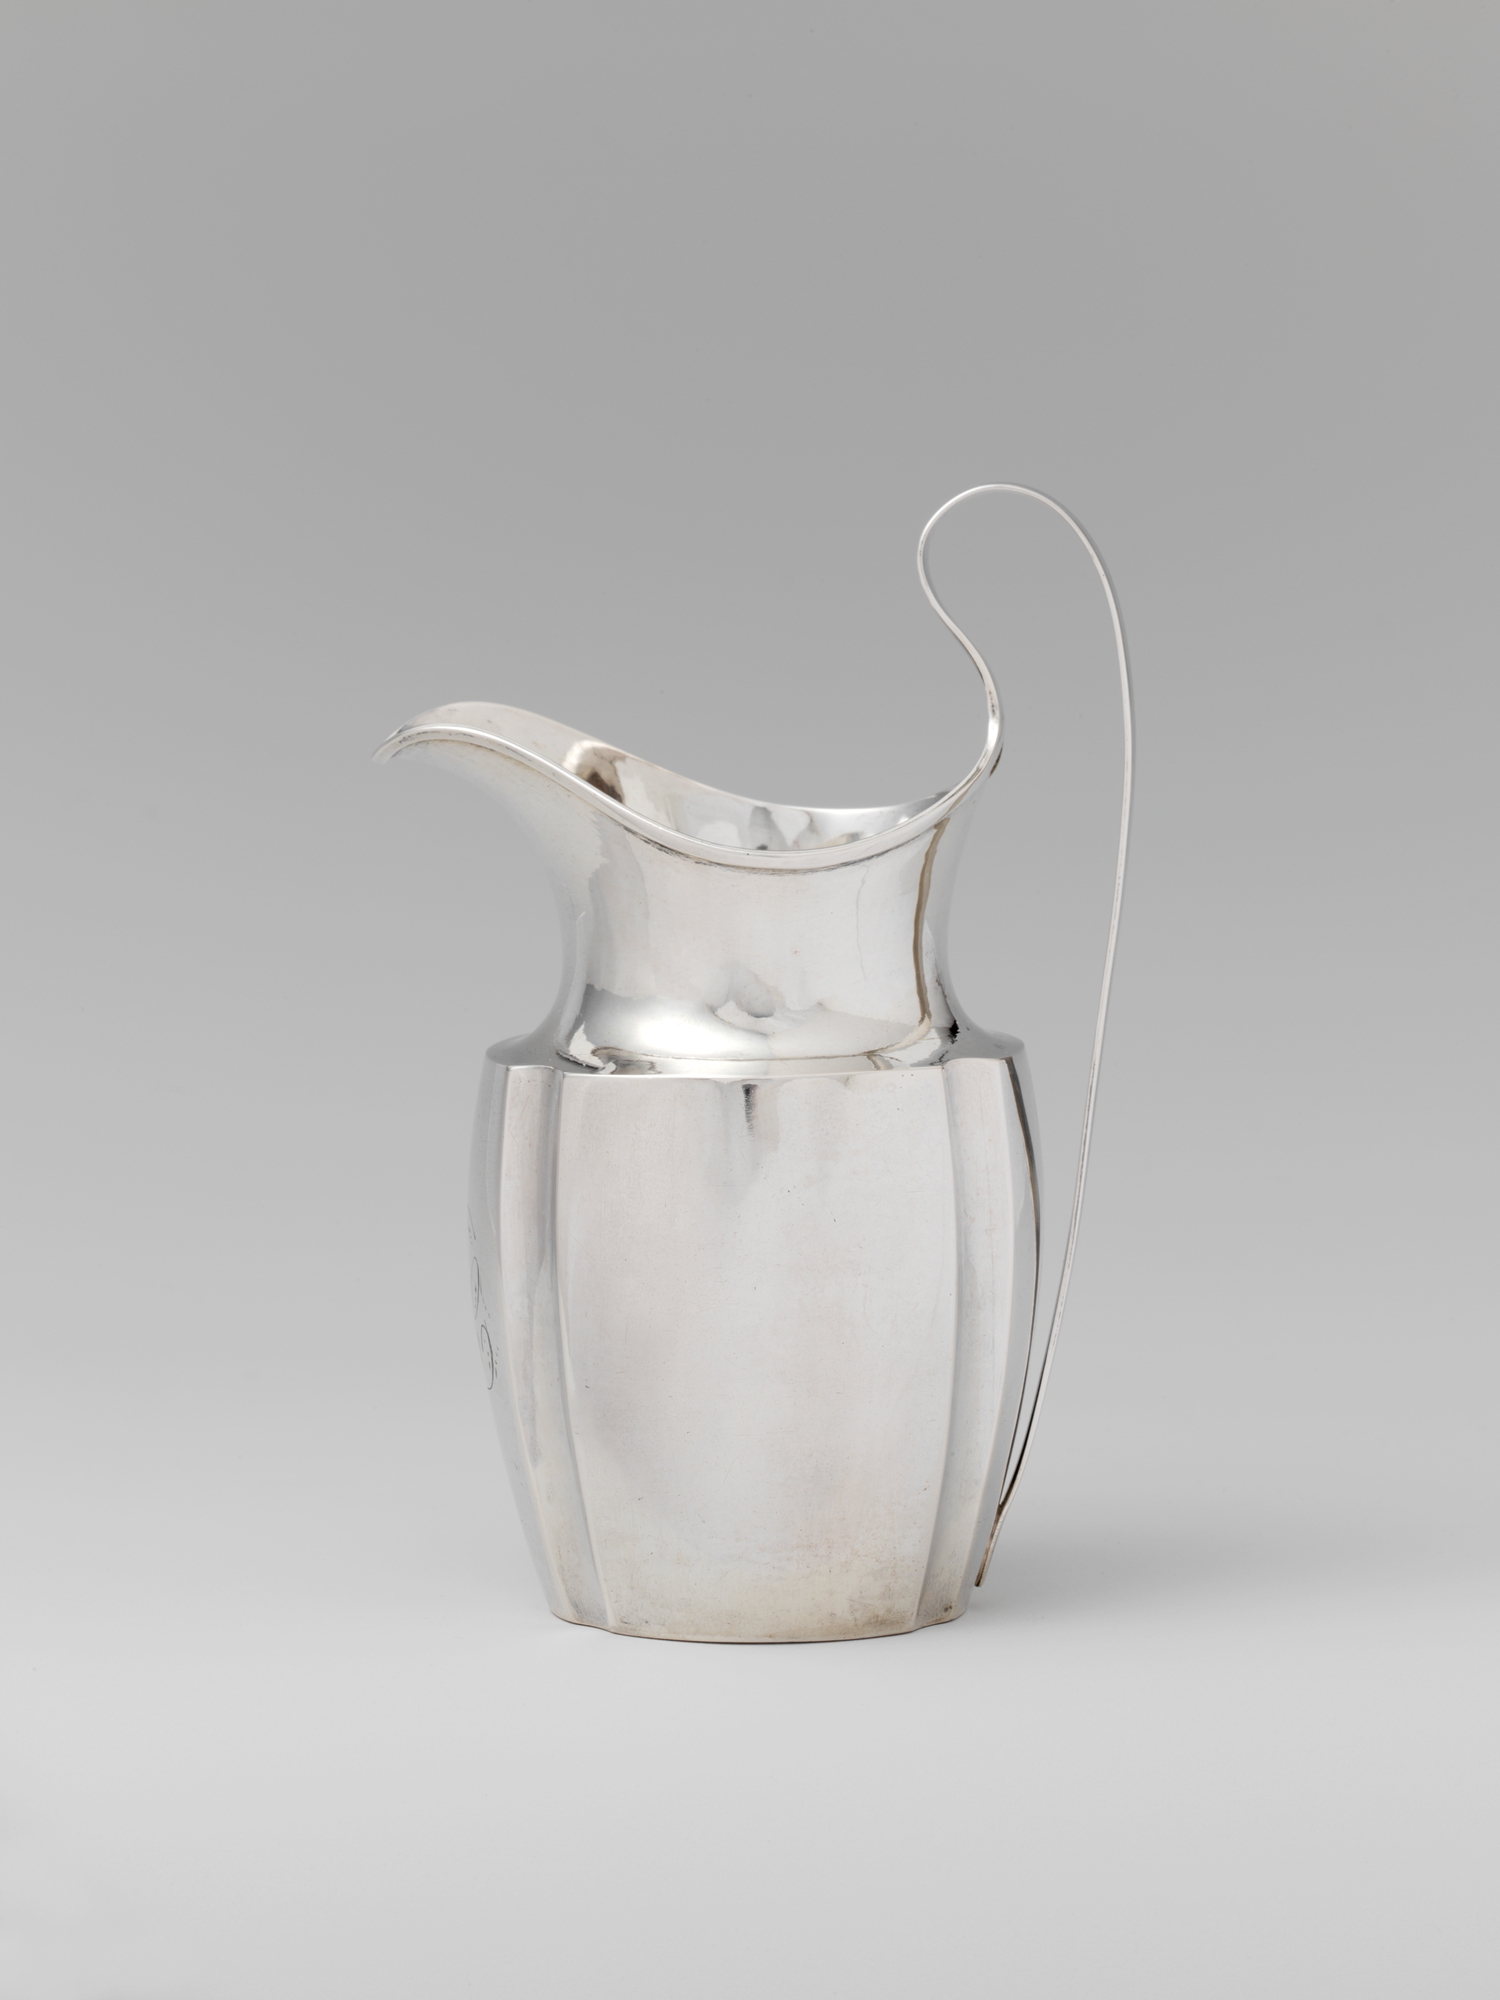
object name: cream pot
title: Creamer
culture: american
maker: joseph moulton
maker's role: maker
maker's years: 1744-1816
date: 1800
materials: silver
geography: united states